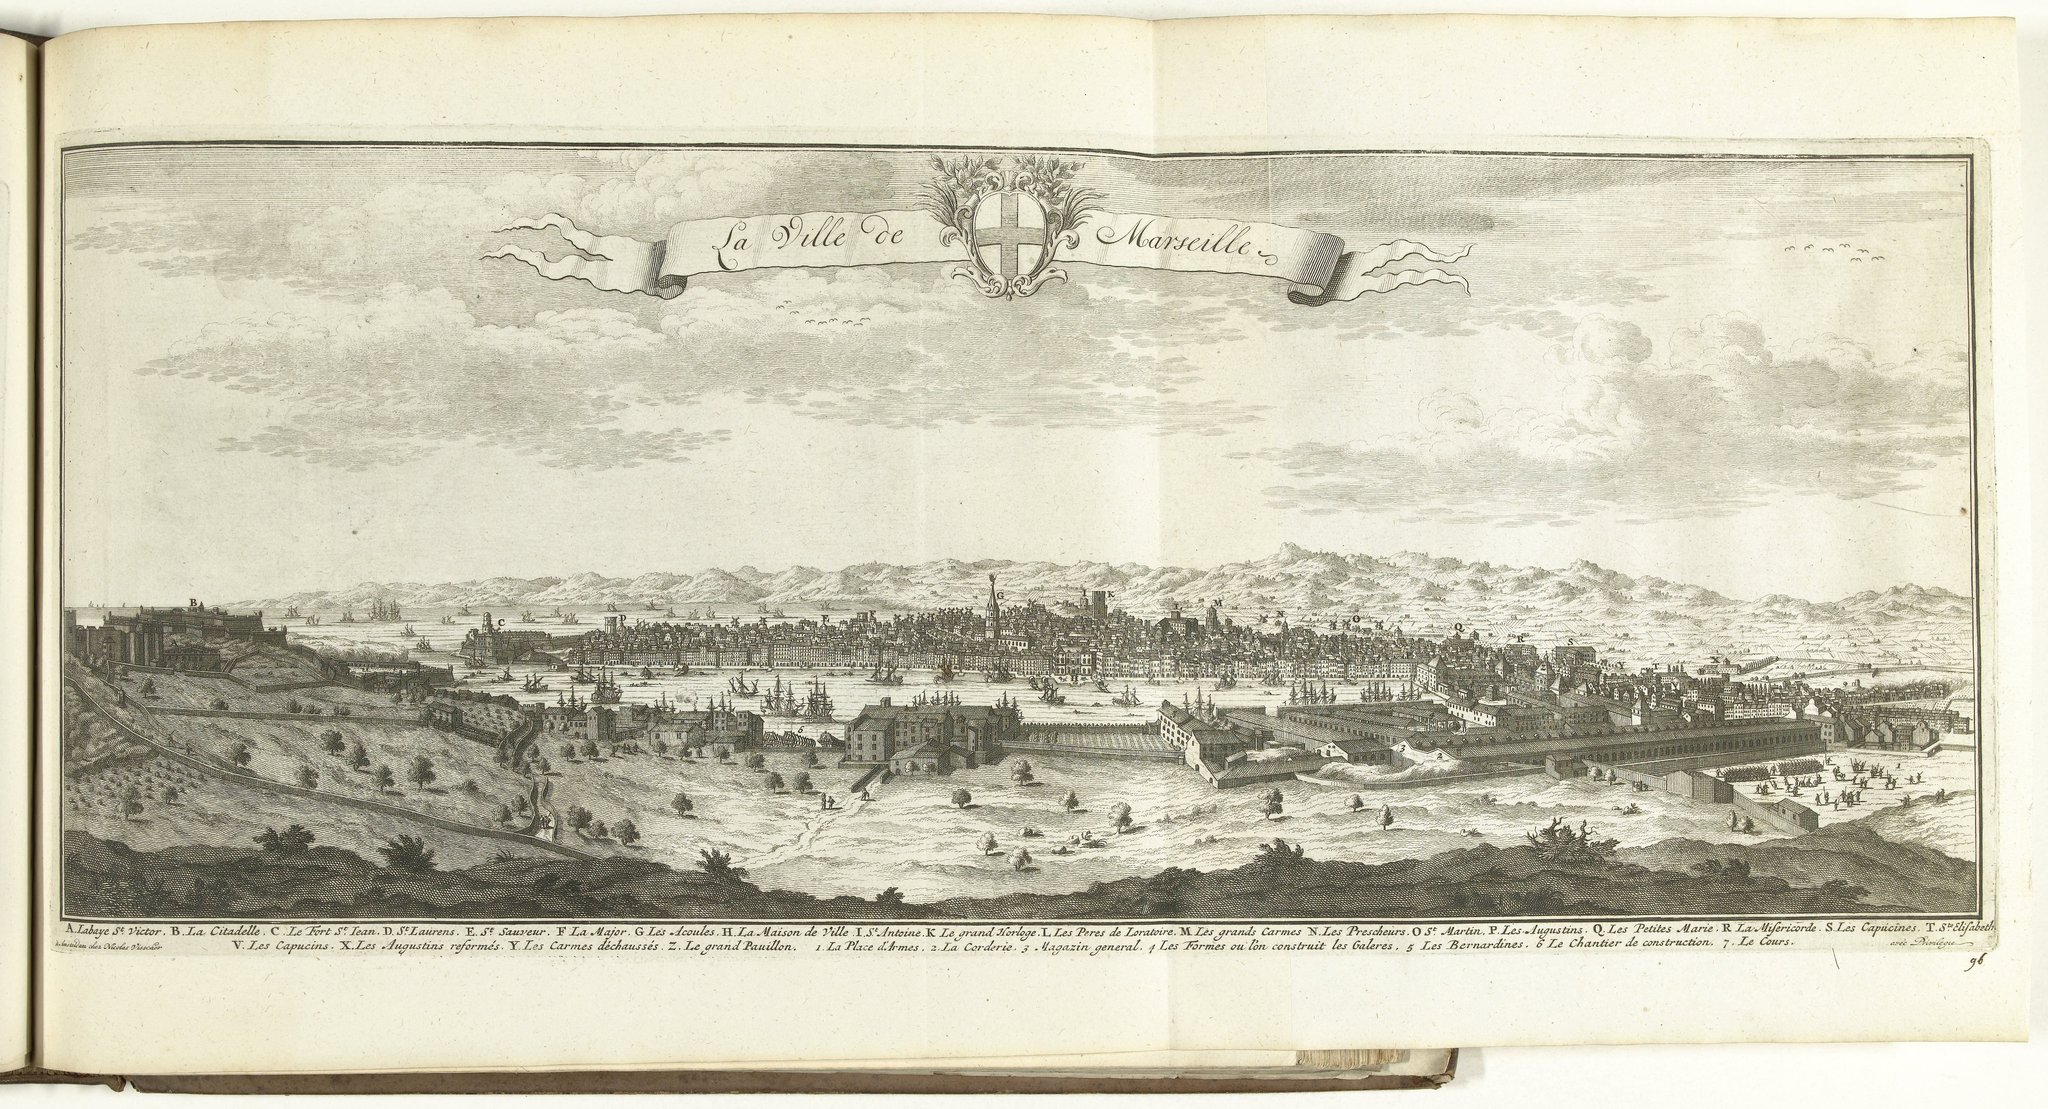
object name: print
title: La Ville de Marseille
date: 1726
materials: paper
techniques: etching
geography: northern netherlands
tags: marseille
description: Gezicht op de Franse havenstad Marseille. Plaat nr. 96 in deel IV van het prentwerk: Les Forces de l'Europe, Asie, Afrique et Amerique ... Comme aussi les Cartes des Côtes de France et d'Espagne uit 1726, dit eerste deel met 238 met de hand genummerde platen van vermaarde sterke steden en vestingen in het kader van de Spaanse Successieoorlog 1701-1713. Voor het merendeel zijn deze platen gekopieerd naar de anonieme Franse platen van vermaarde sterke steden en vestingen: in Les forces de l'Europe en in: Le theatre de la guerre, dans les Pays-Bas, beide oorspronkelijk uitgegeven door Nicolas de Fer te Parijs (1693-1697) in het kader van de Negenjarige Oorlog. Titel en opschriften in het Frans.